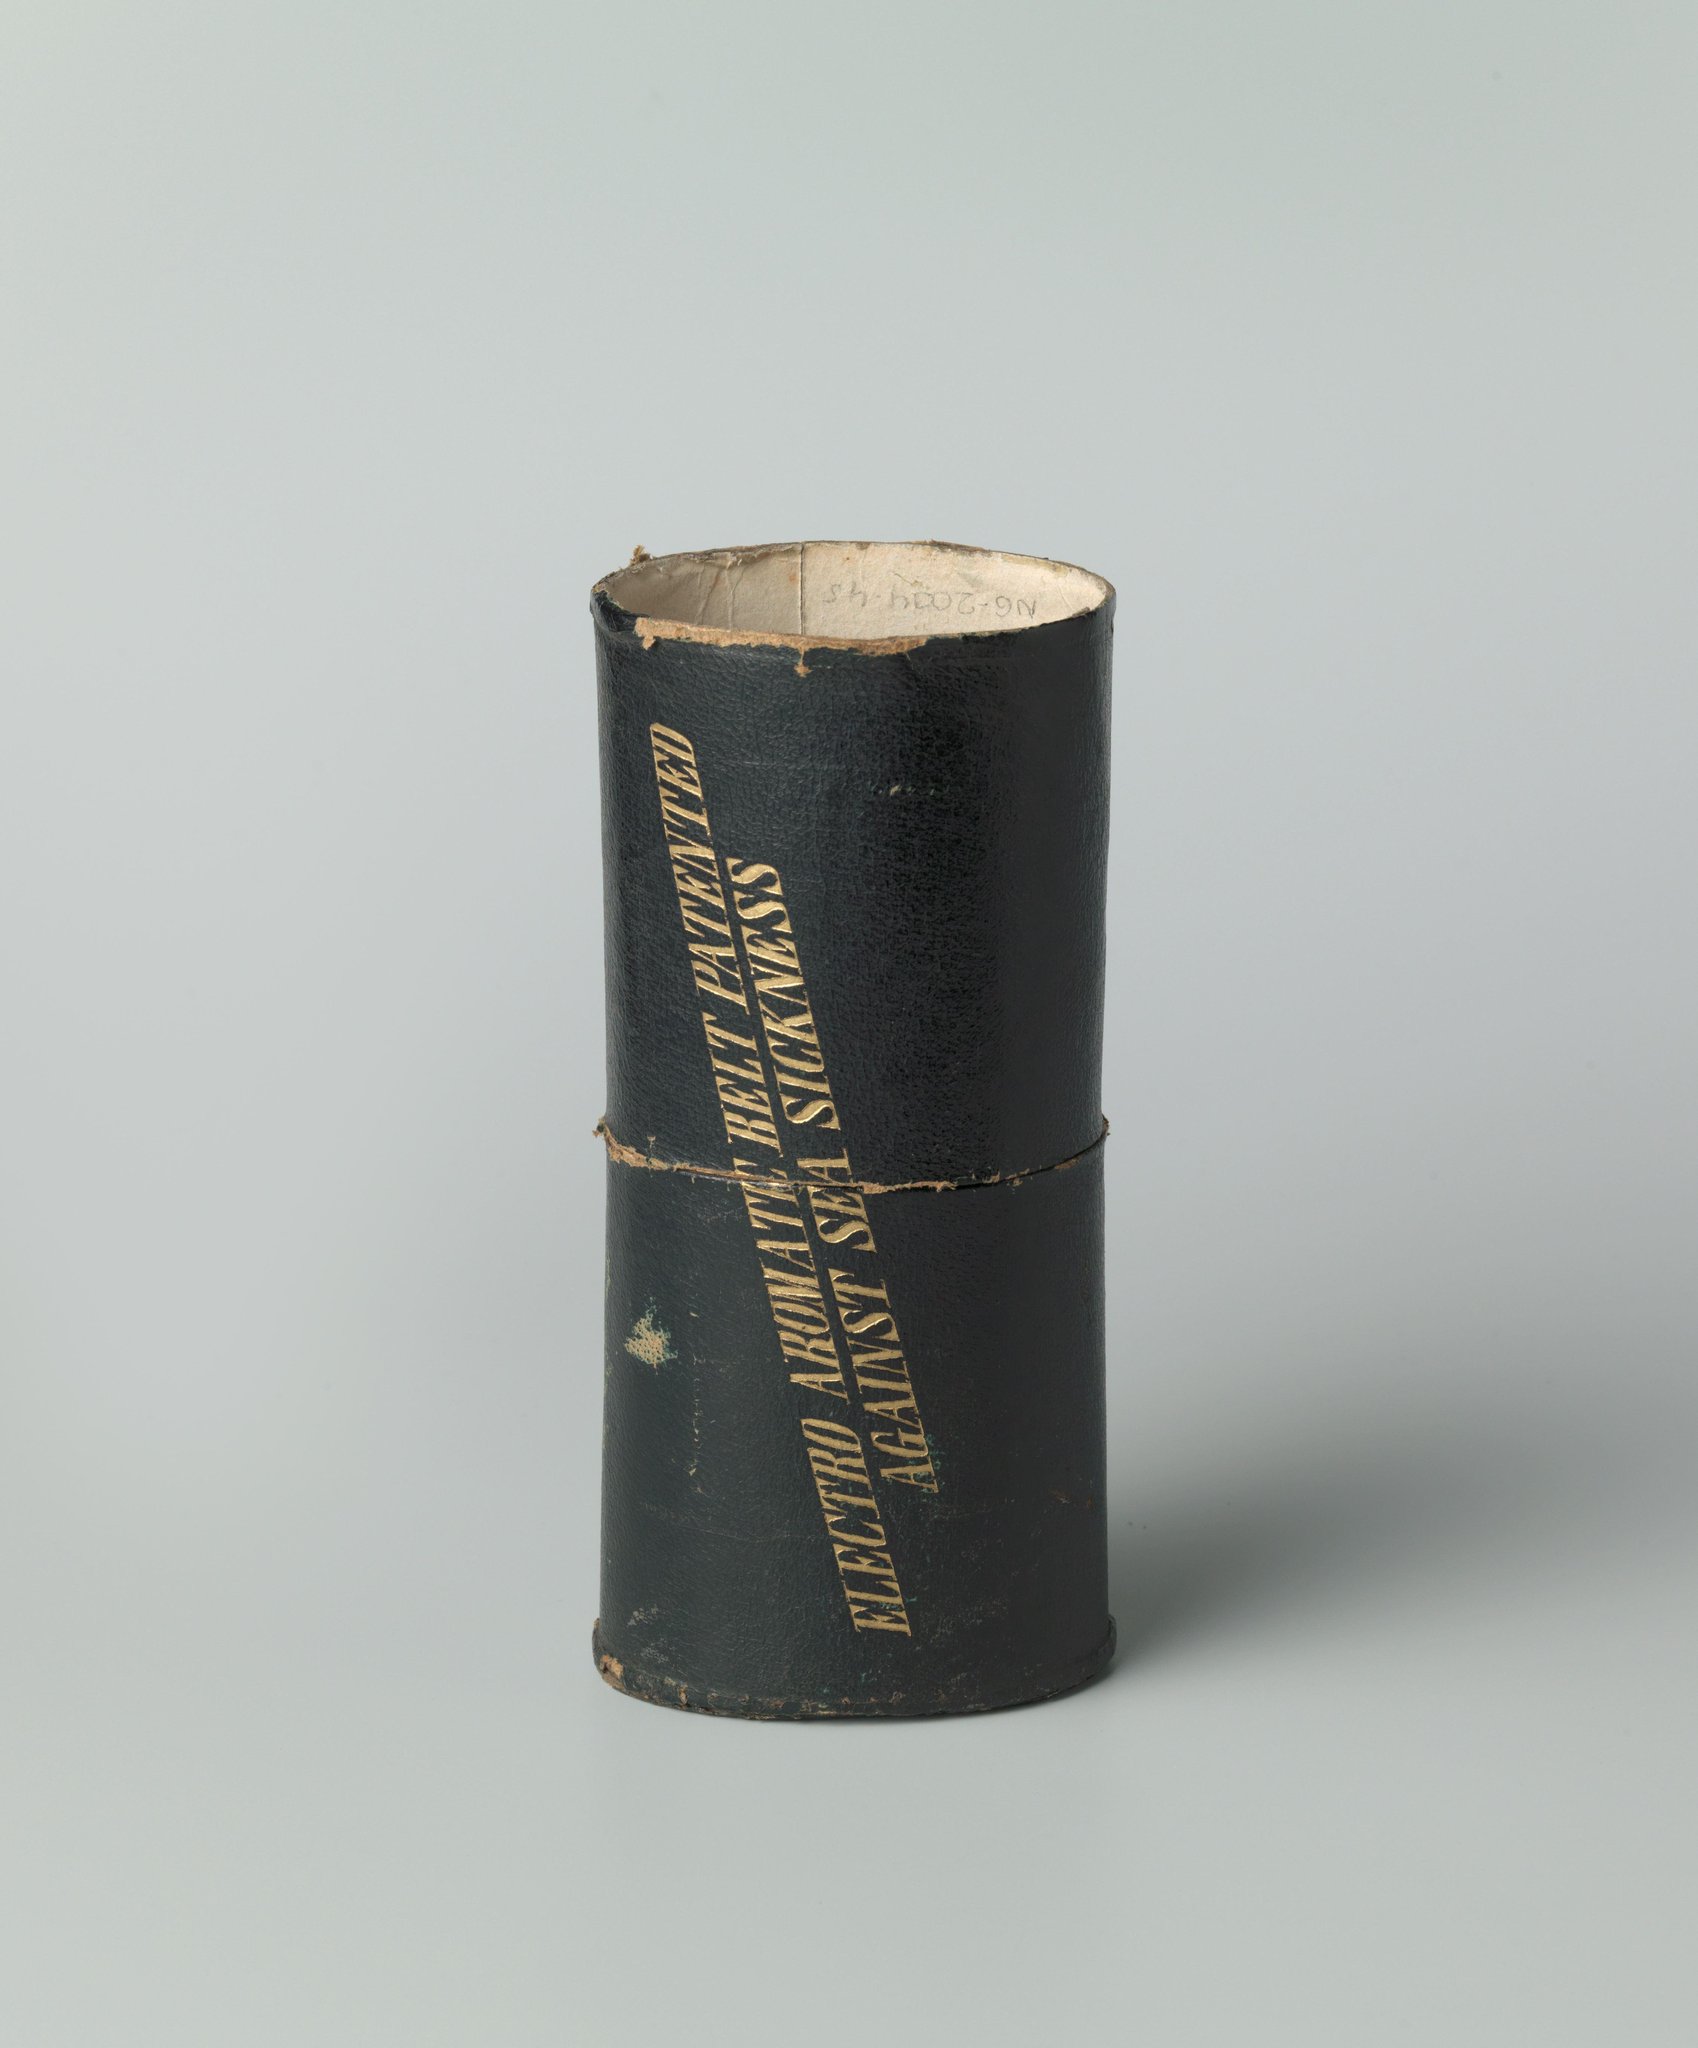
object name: case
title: Foedraal horende bij een riem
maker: alphonse l.e. mosselman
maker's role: uitvinder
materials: cardboard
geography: brussels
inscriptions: inscription: ‘DEPOSE A.M. & CIE’, inscription: ‘ELECTRO AROMATIC BELT PATENTED AGAINST SEA SICKNESS’, inscription: ‘PATENT DIEU ET MON DROIT HONY SOIT QUI MAL Y PENSE’, inscription: ‘BRÉVETÉ L'UNION ...FORCE’, inscription: ‘BRÉVETÉ’, inscription: ‘GERREVETEERT JE MAINTIENDRAI’, inscription: ‘CEINTURE AROMALE ELECTRIQUE CONTRE LE MAL DE MER’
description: Een zwart ovalen foedraal met gouden opdruk. Zijkant kapot.